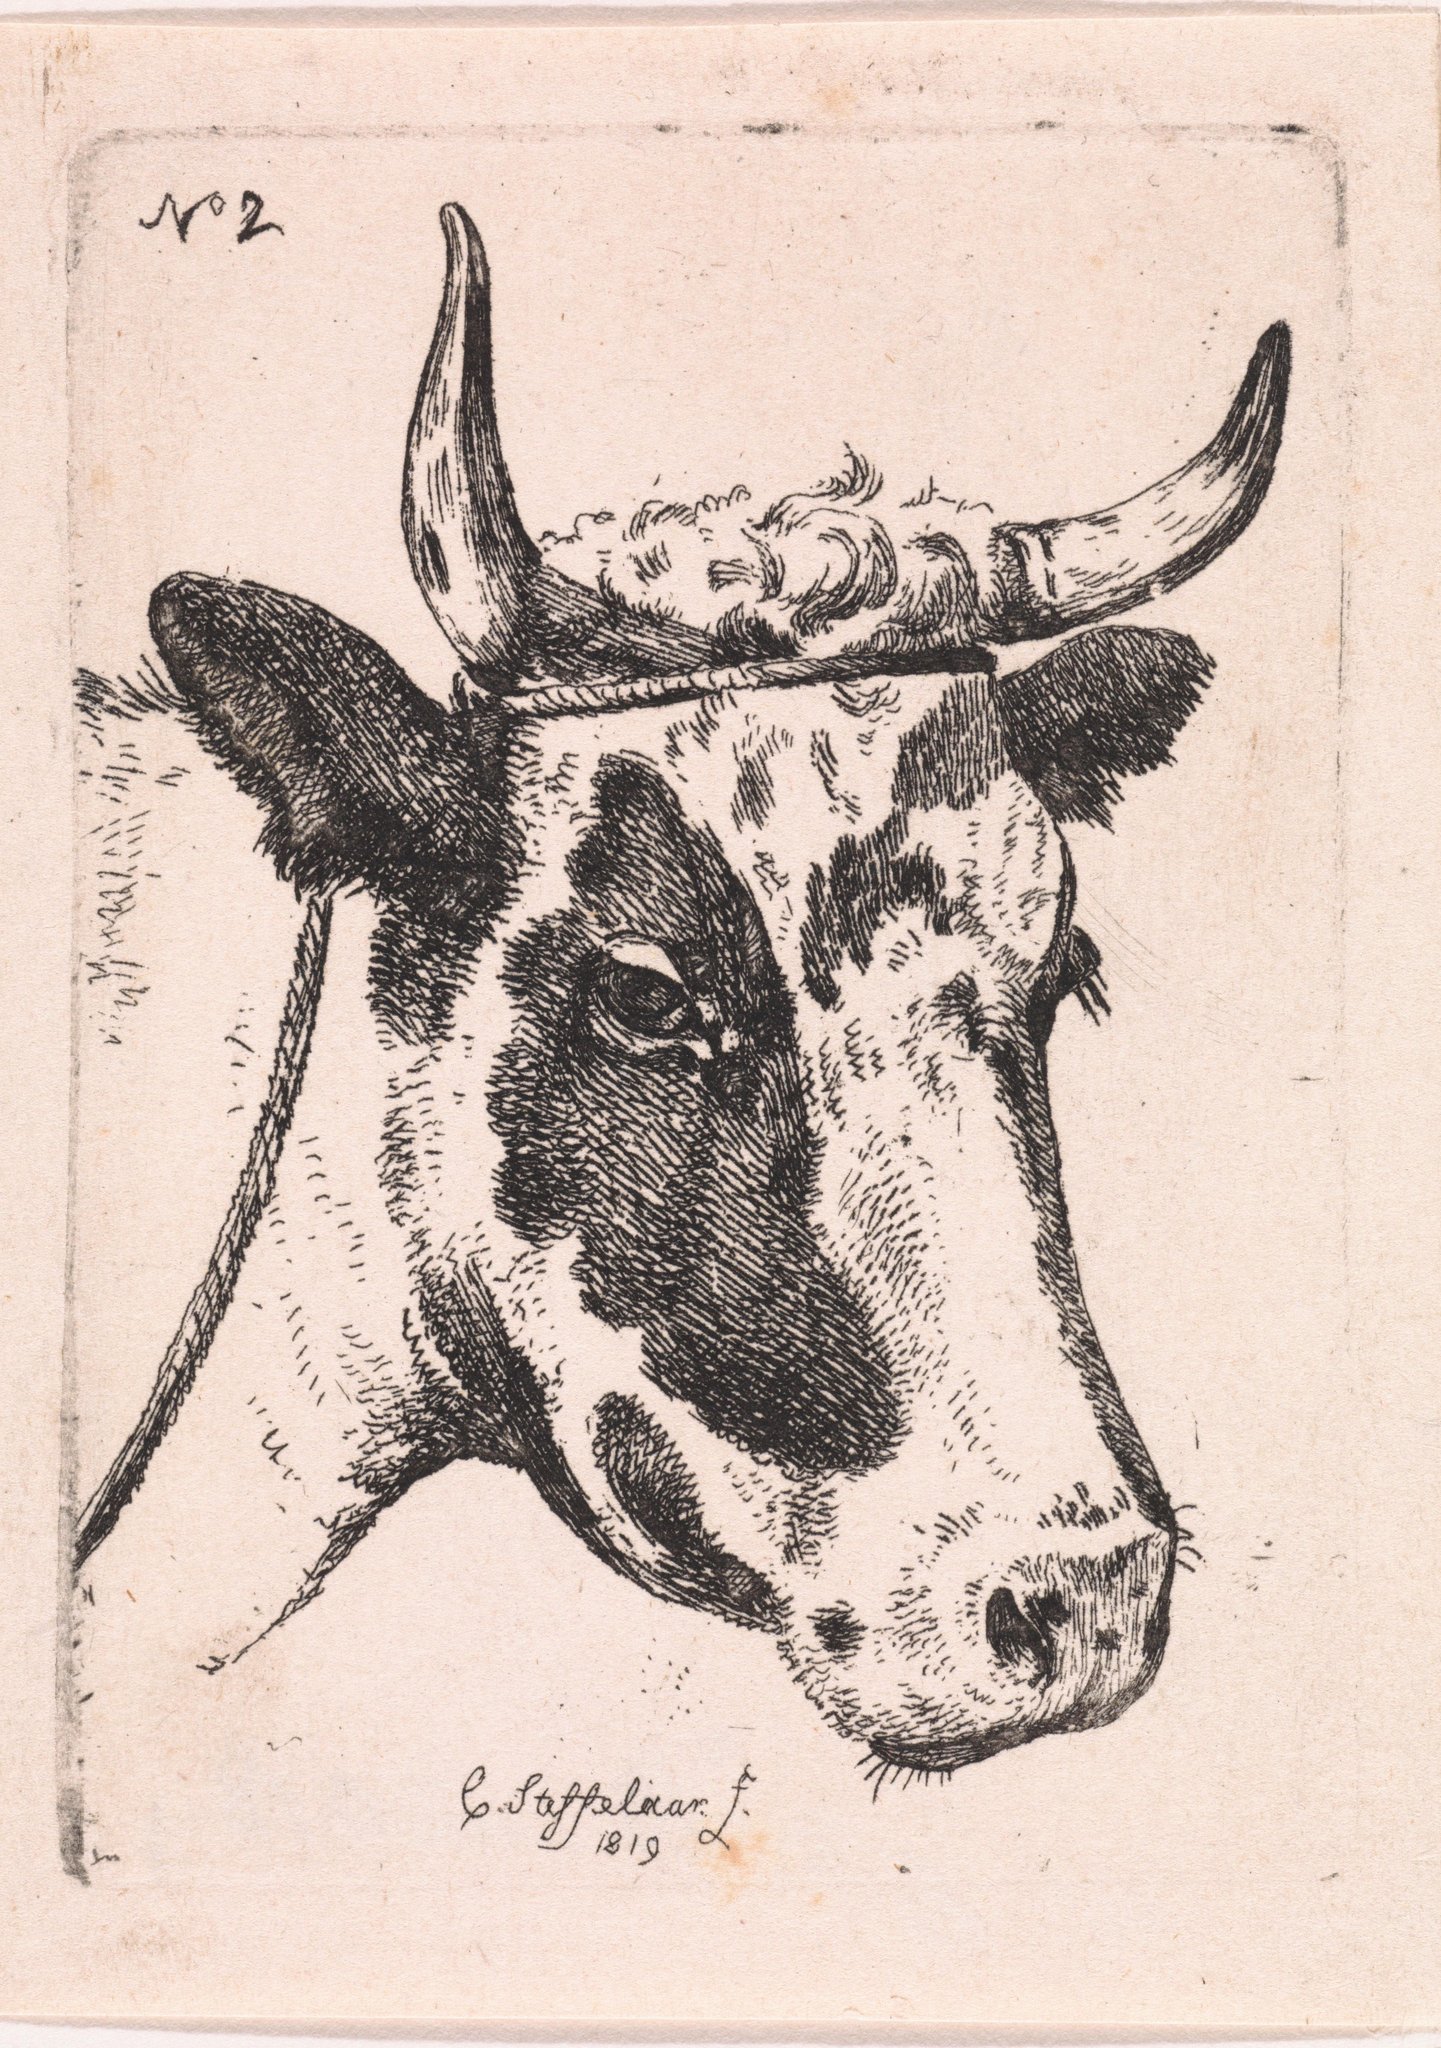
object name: print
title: Eerste suite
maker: cornelis steffelaar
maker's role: draughtsman, painter, print maker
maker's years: 1797-1861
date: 1819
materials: paper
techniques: etching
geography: amsterdam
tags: cow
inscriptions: collector's mark: Lugt 2228